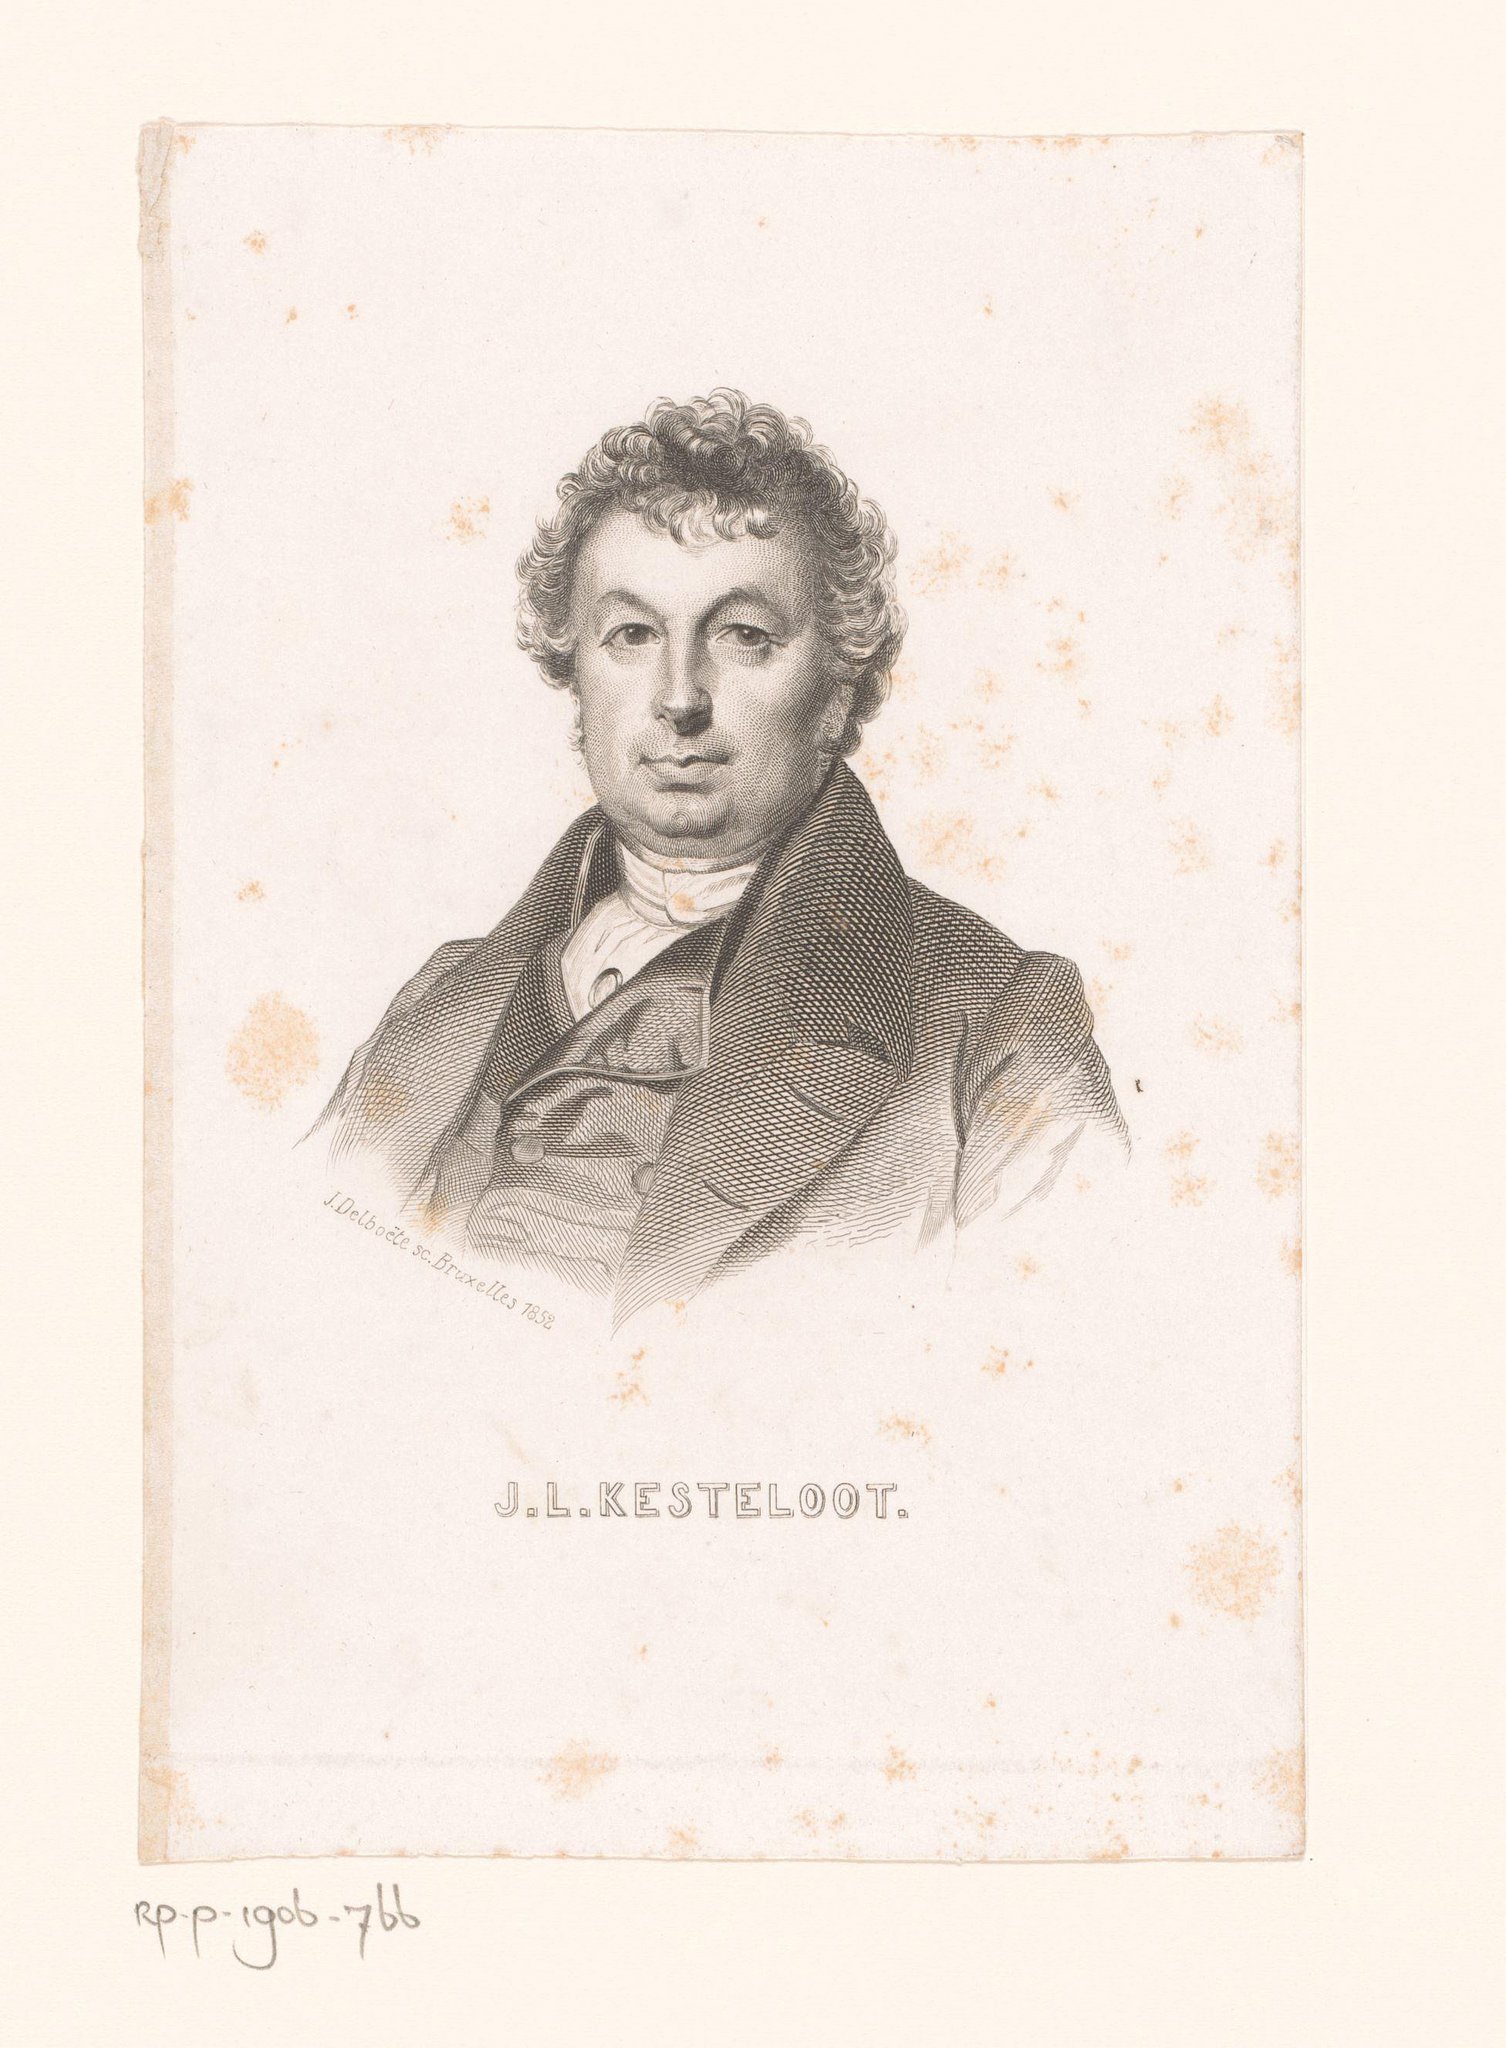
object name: print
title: Portret van Jacques Louis Kesteloot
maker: joseph delboëte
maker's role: draughtsman, print maker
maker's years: 1825-1875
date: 1835-1875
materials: paper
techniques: engraving, etching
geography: brussels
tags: ghent, historical person (...) - historical person (...) portrayed alone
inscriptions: collector's mark: Lugt 2228